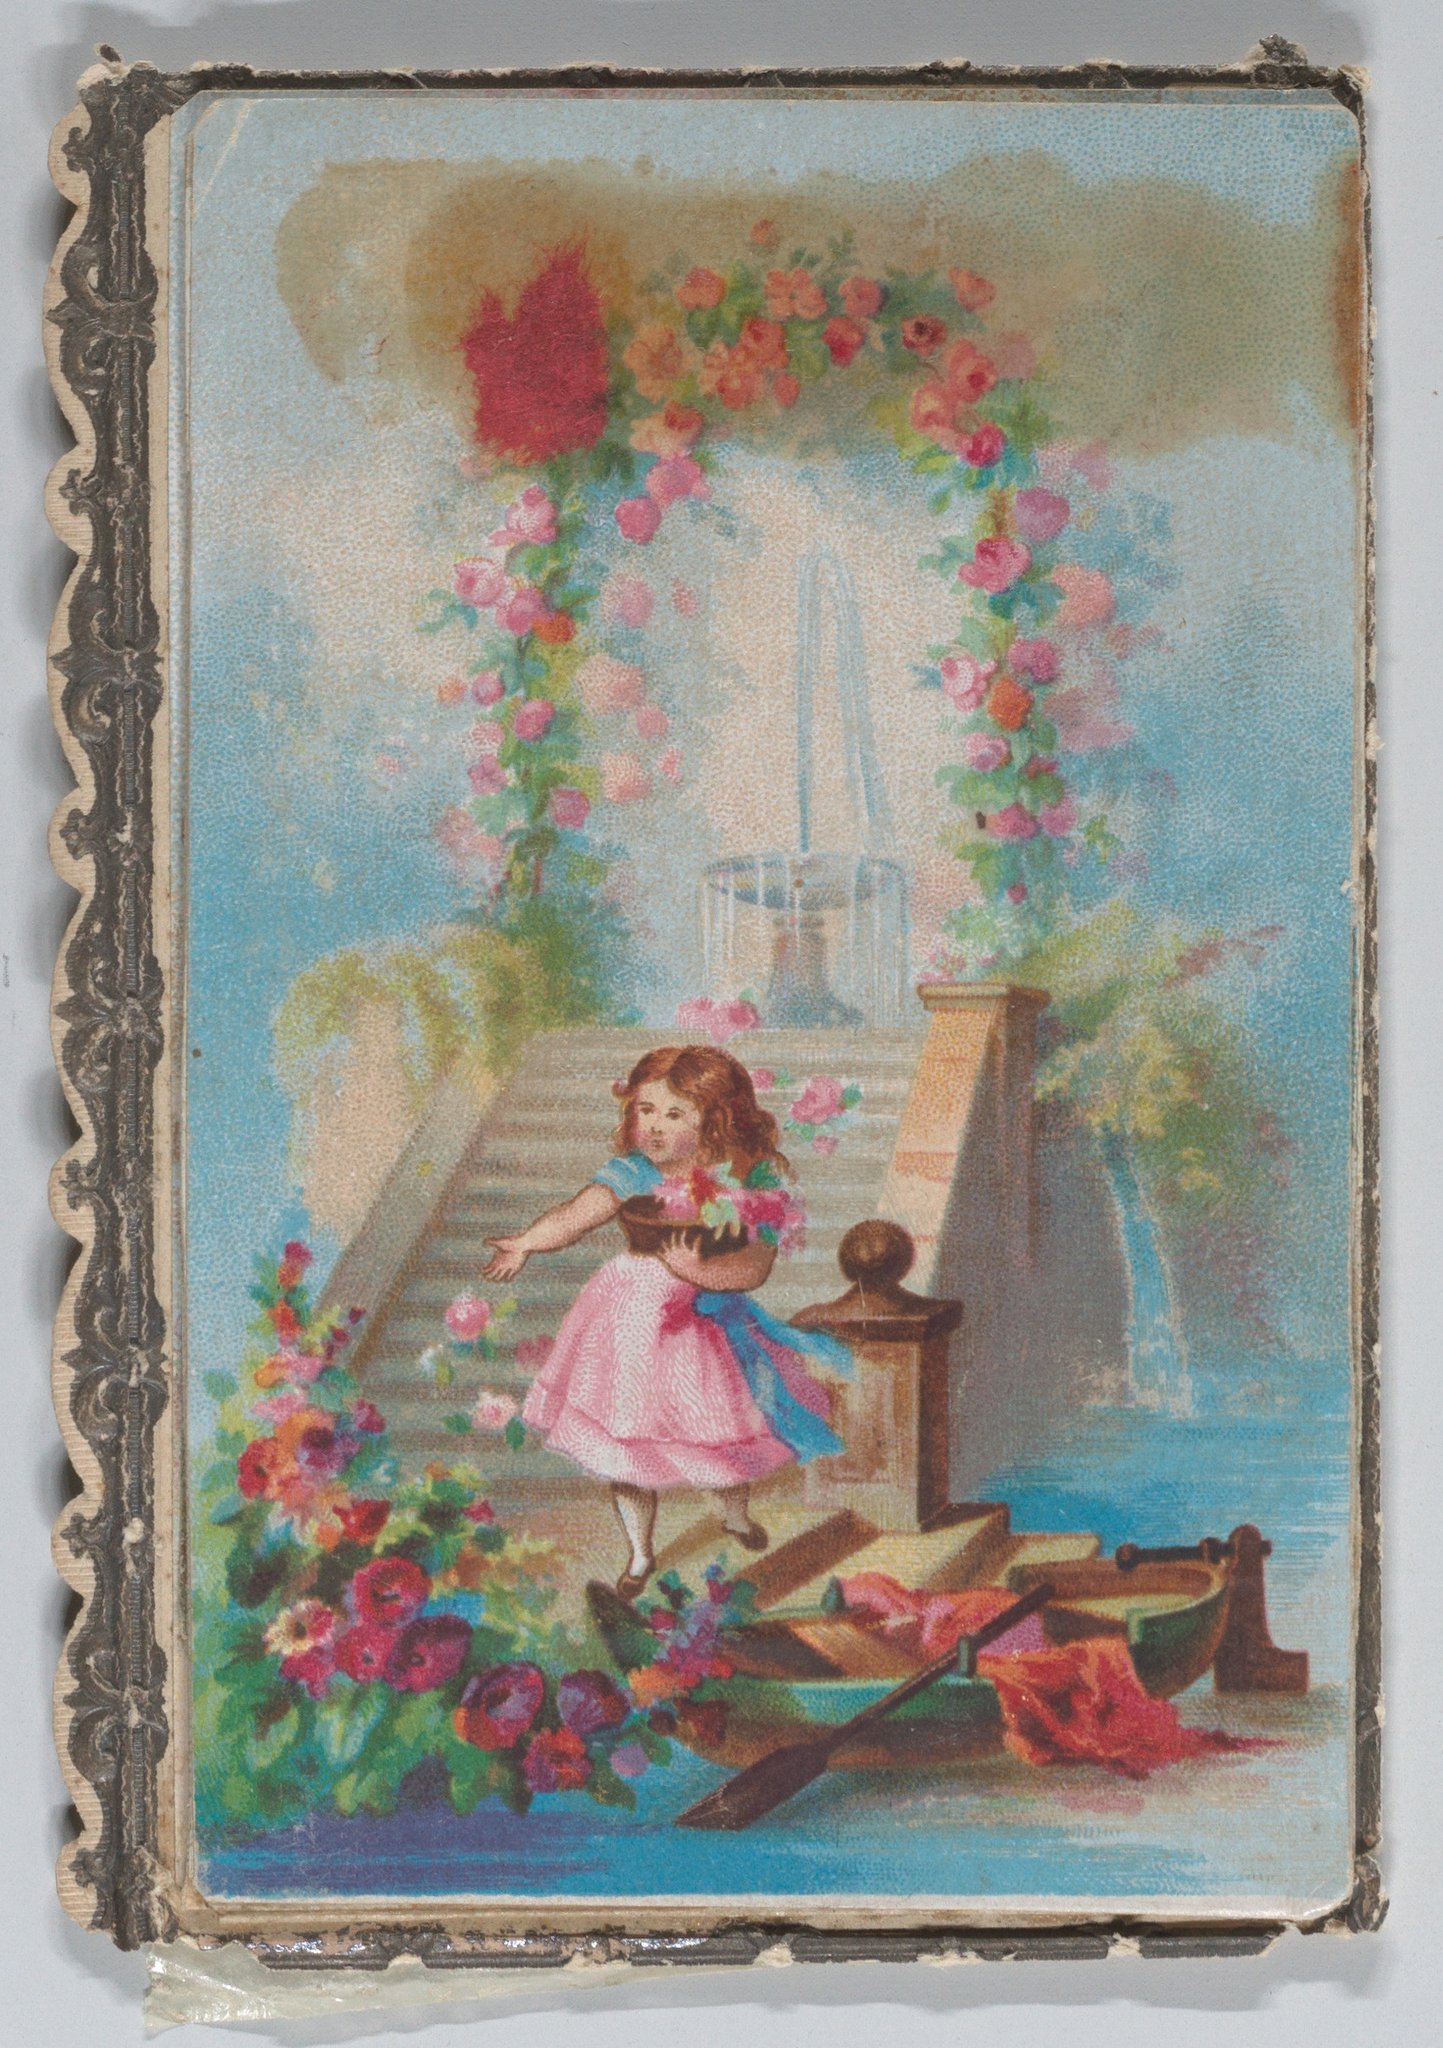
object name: valentine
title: Valentine - Mechanical -- four layers, merrymaking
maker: anonymous, german, 19th century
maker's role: artist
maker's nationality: german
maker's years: 1800-1899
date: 1875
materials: ribbon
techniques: chromolithography, cutting